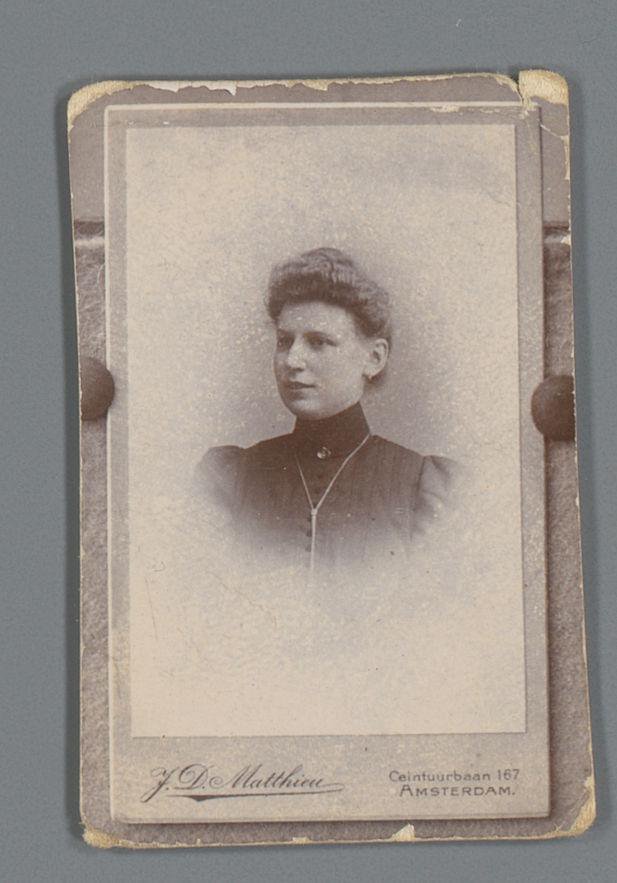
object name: photograph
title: Fotoreproductie van het portret van een onbekende vrouw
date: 1890-1910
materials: paper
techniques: collodion silver print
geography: amsterdam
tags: adult woman, anonymous historical person portrayed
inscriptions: address: ‘Ceintuurbaan 167/ AMSTERDAM.’